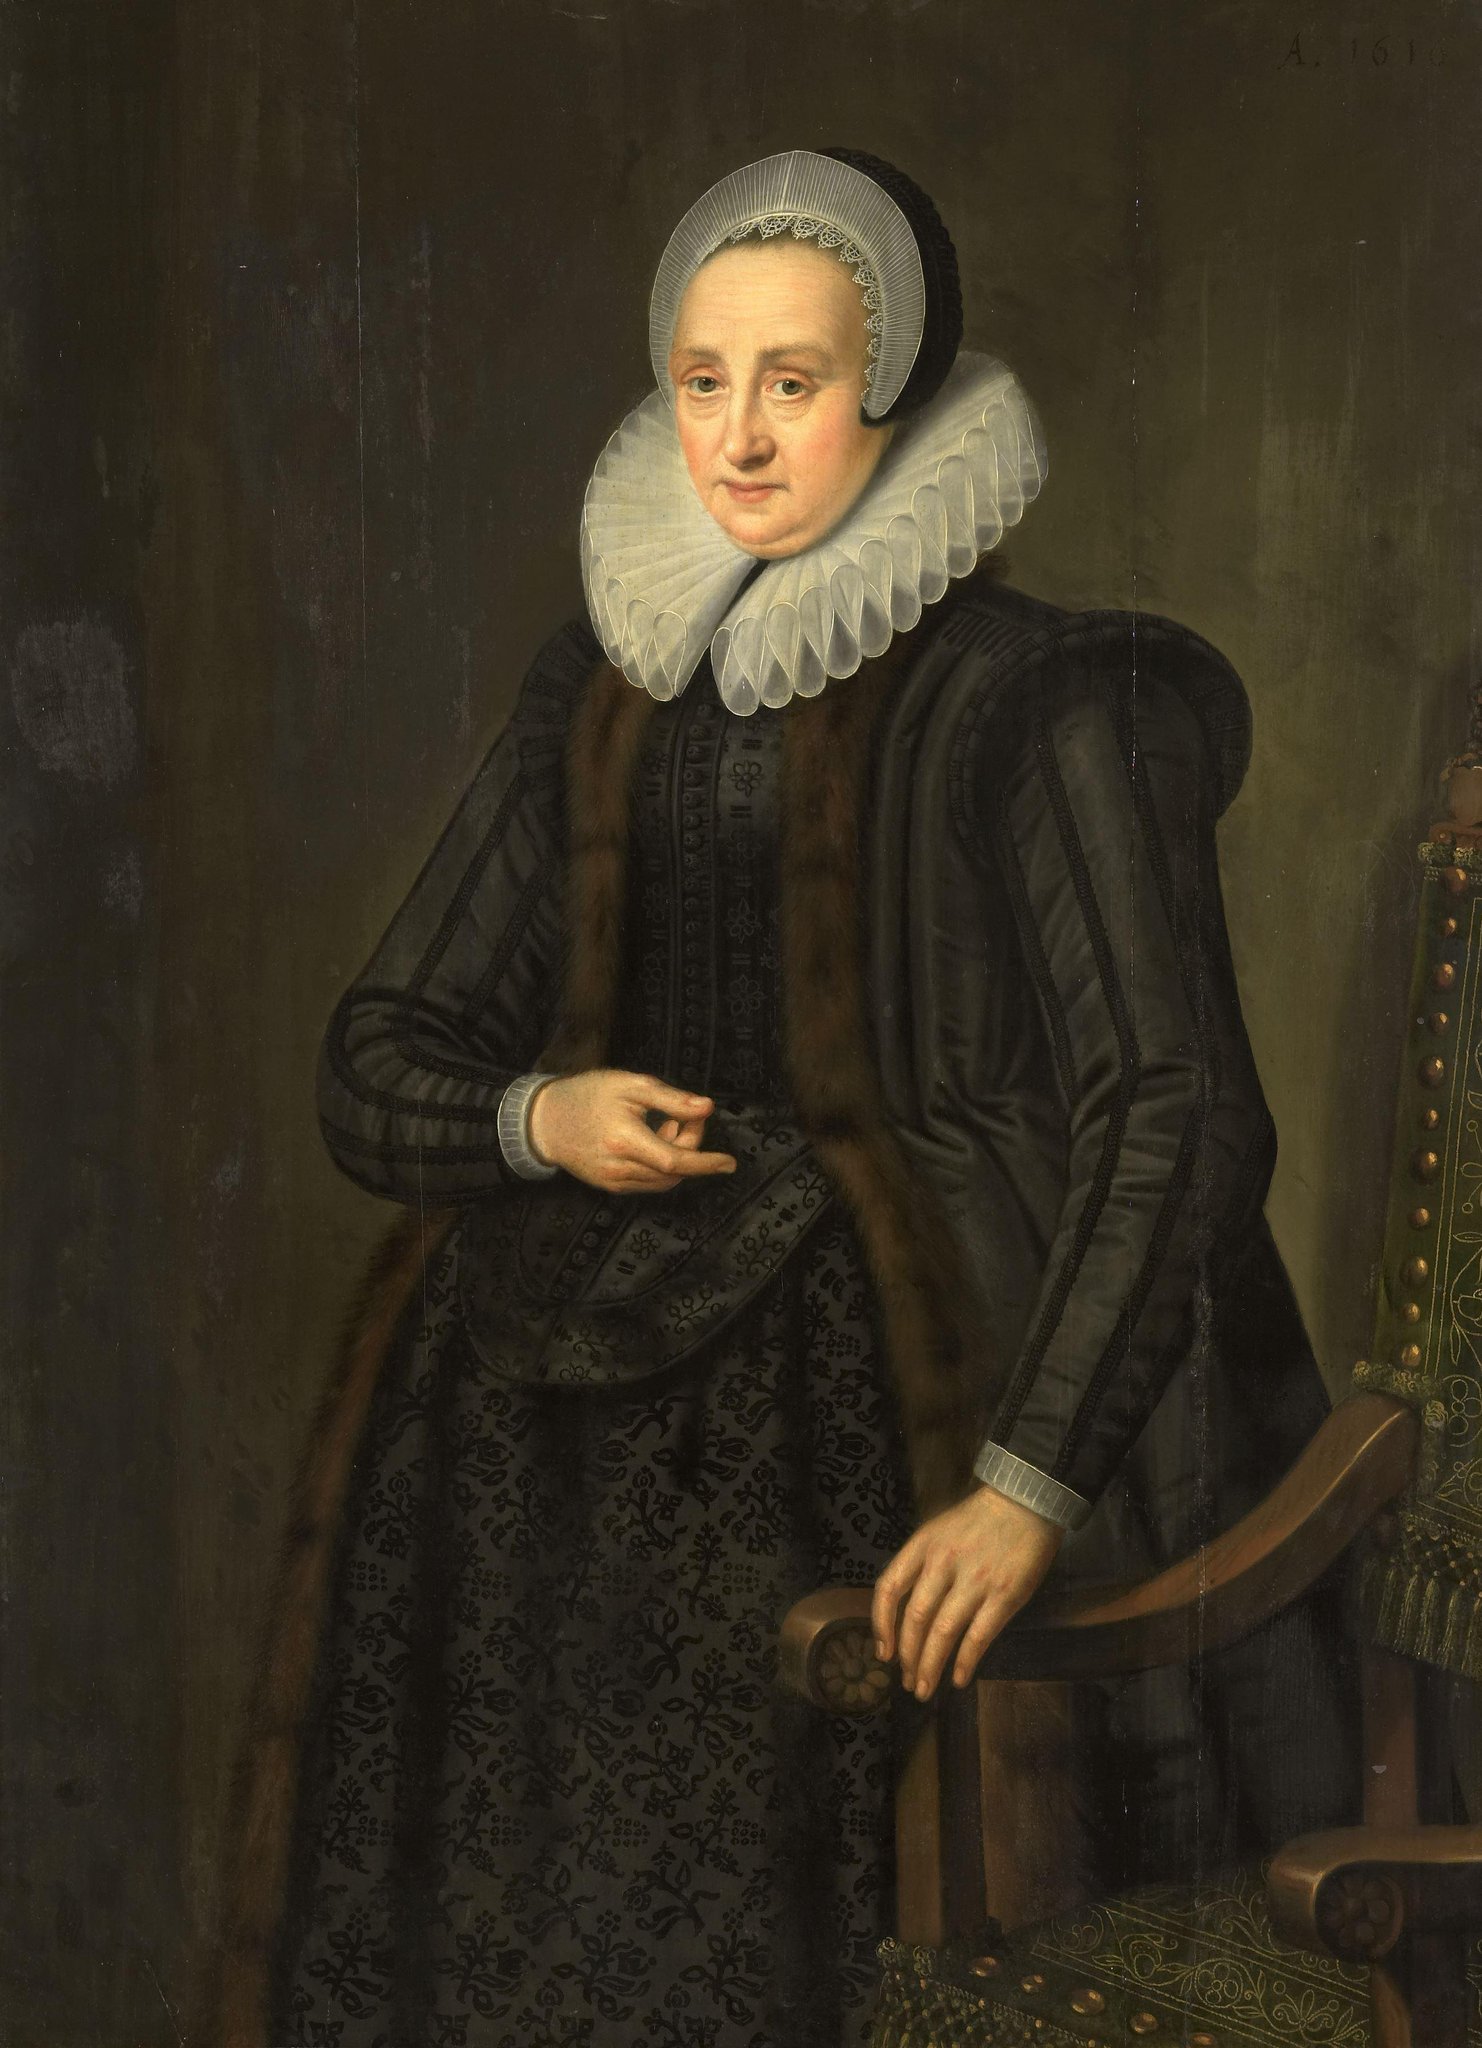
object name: painting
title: Portrait of Margarita Cassier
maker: Anonymous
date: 1616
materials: oil, panel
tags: historical persons - bb - woman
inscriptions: inscription, on the reverse: ‘Margarita Cassier. / Trouwt Junij 1563 Gilliam Courten.’, inscription, on the reverse: ‘21’, date, upper right: ‘Aº 1616’, coat of arms, on the reverse: quartered, 1 and 4, a standing black harrier on a gold field; 2 and 3, a black chevron and three white birds on a red field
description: Portret van Margarita Cassier, echtgenote van Guilliam Courten. Kniestuk, staande naast een leunstoel. Op de achterzijde het familiewapen, een inscriptie en het cijfer 21.